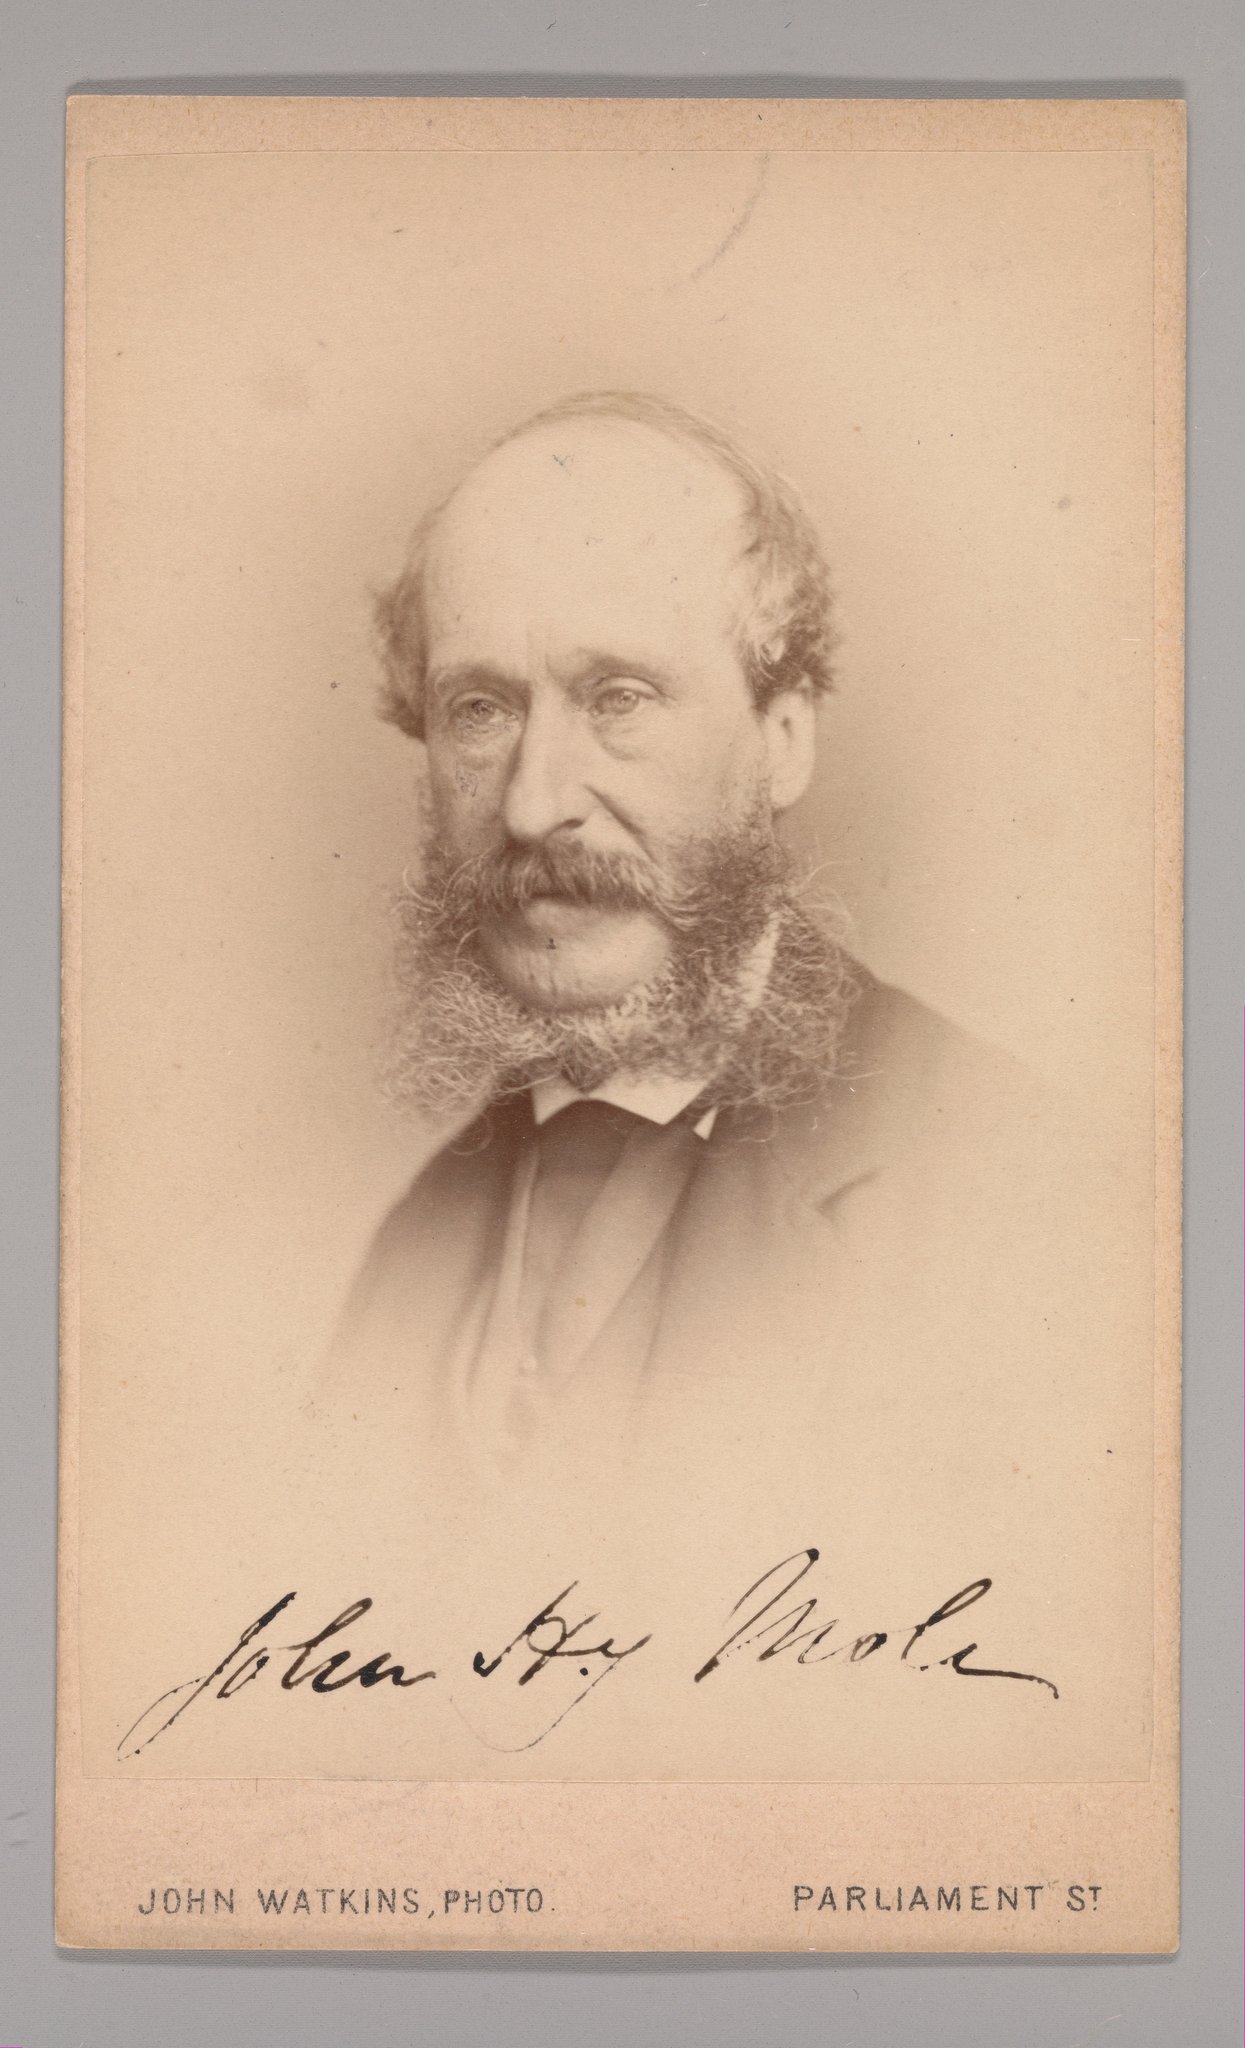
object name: carte de visite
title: [John Henry Mole]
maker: john and charles watkins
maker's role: photography studio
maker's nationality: british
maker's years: 1840-1875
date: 1860-1869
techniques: albumen silver print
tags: men,portraits